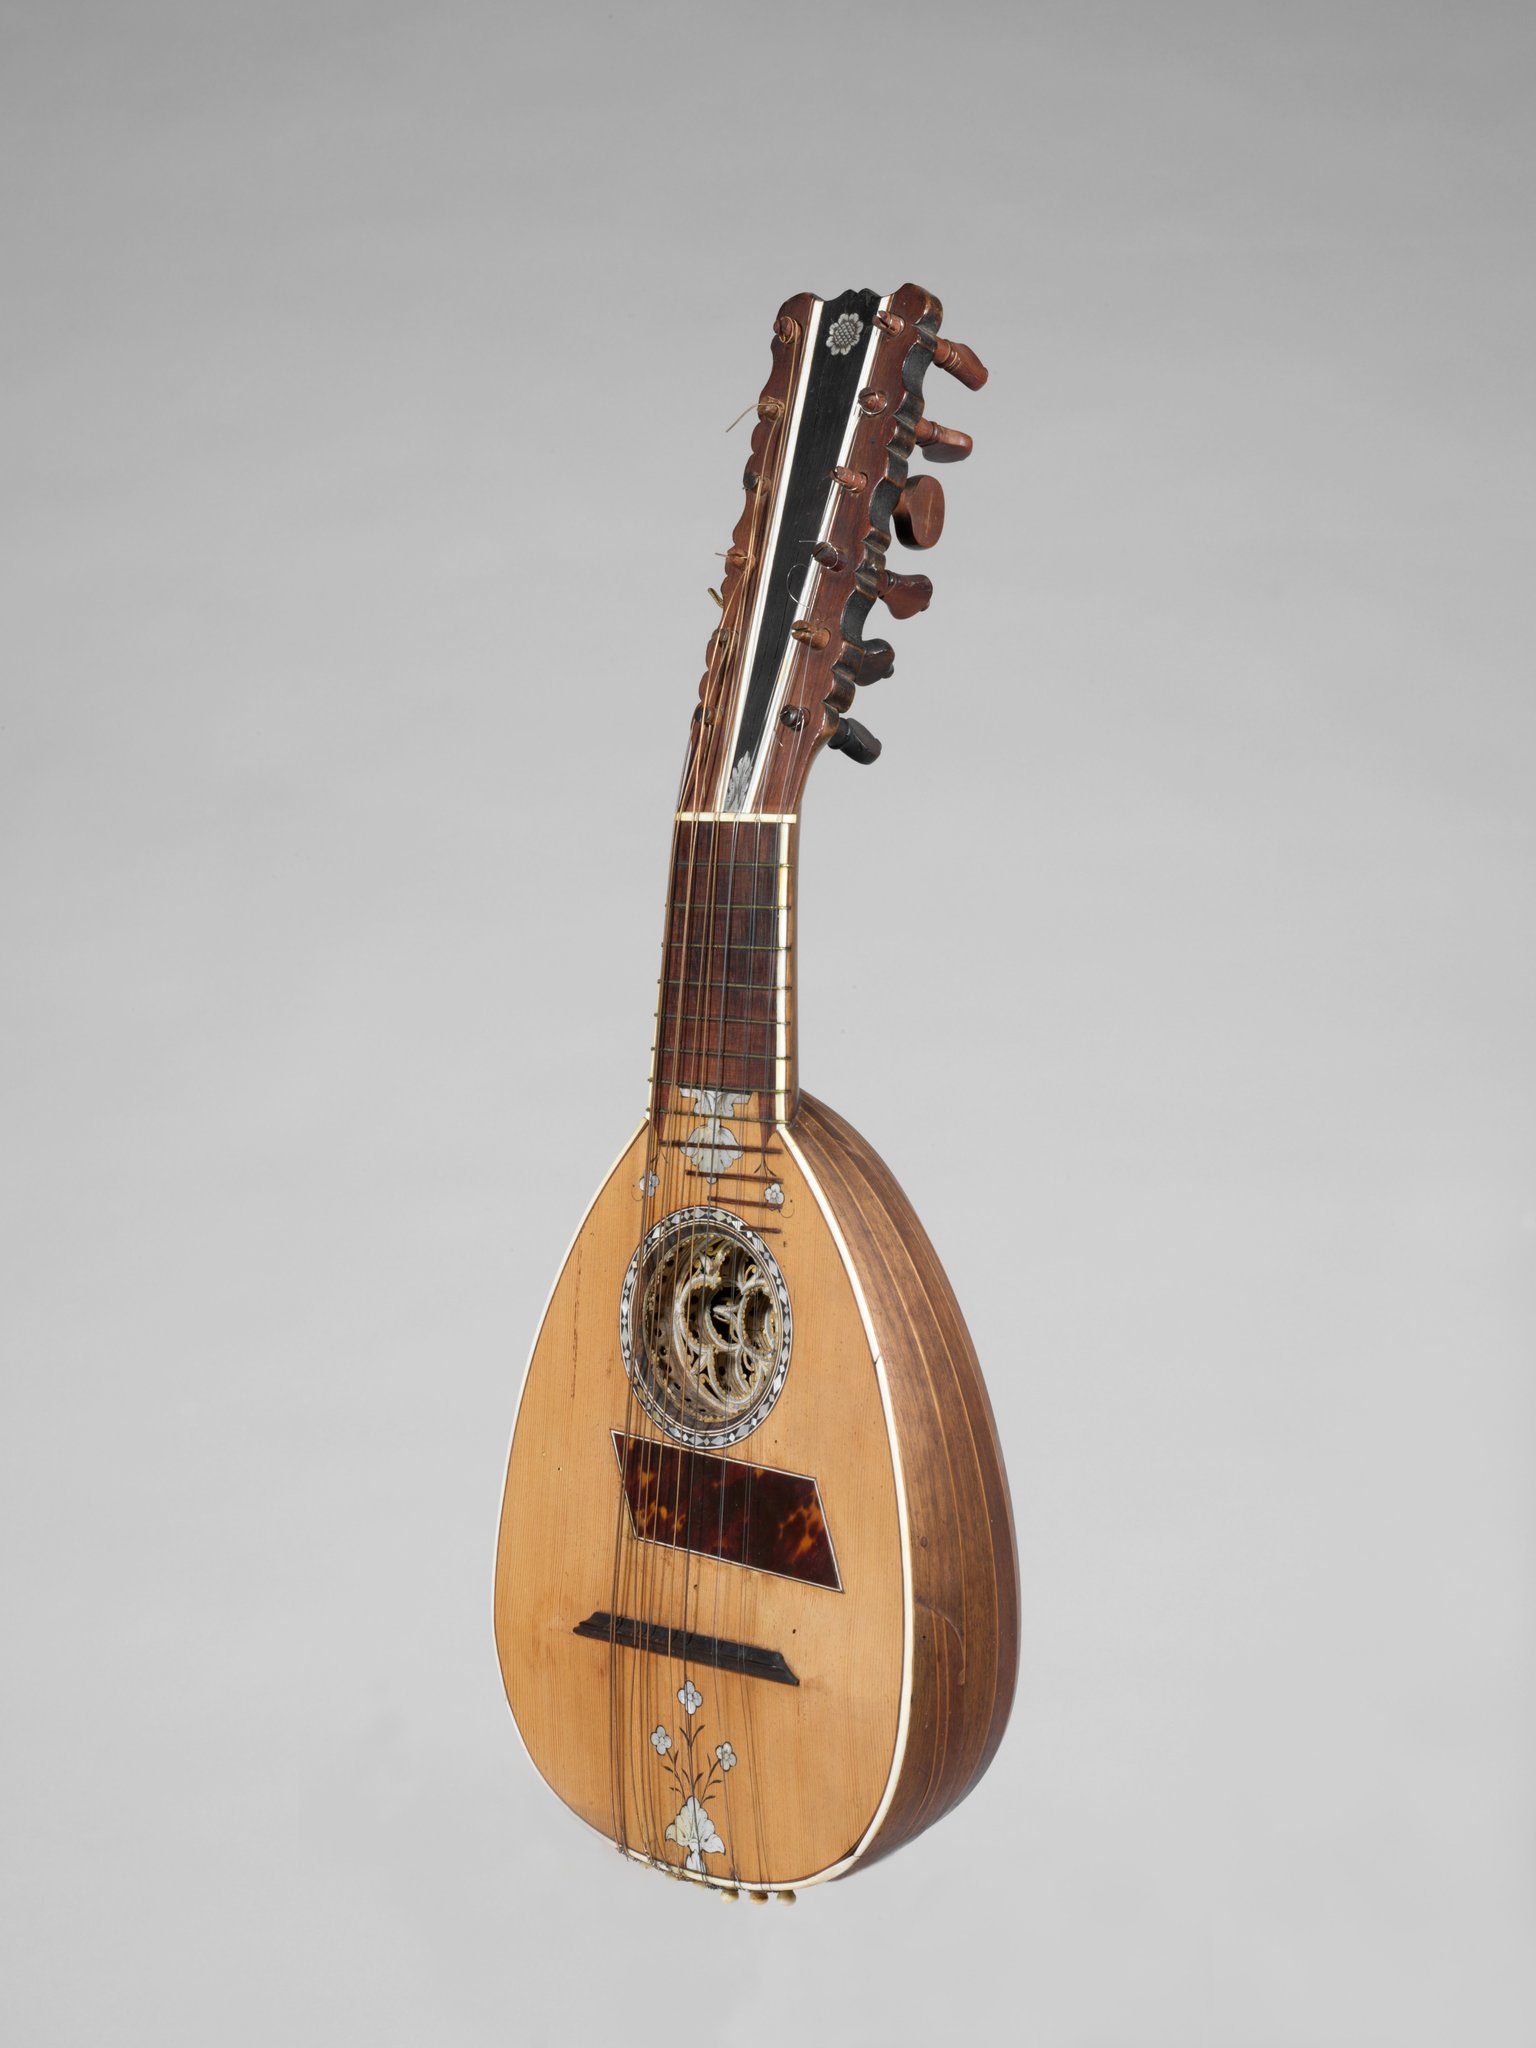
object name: mandolin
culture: italian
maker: christian nonnemacker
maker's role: maker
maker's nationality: german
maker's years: 1750-1765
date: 1701-1800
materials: wood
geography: italy